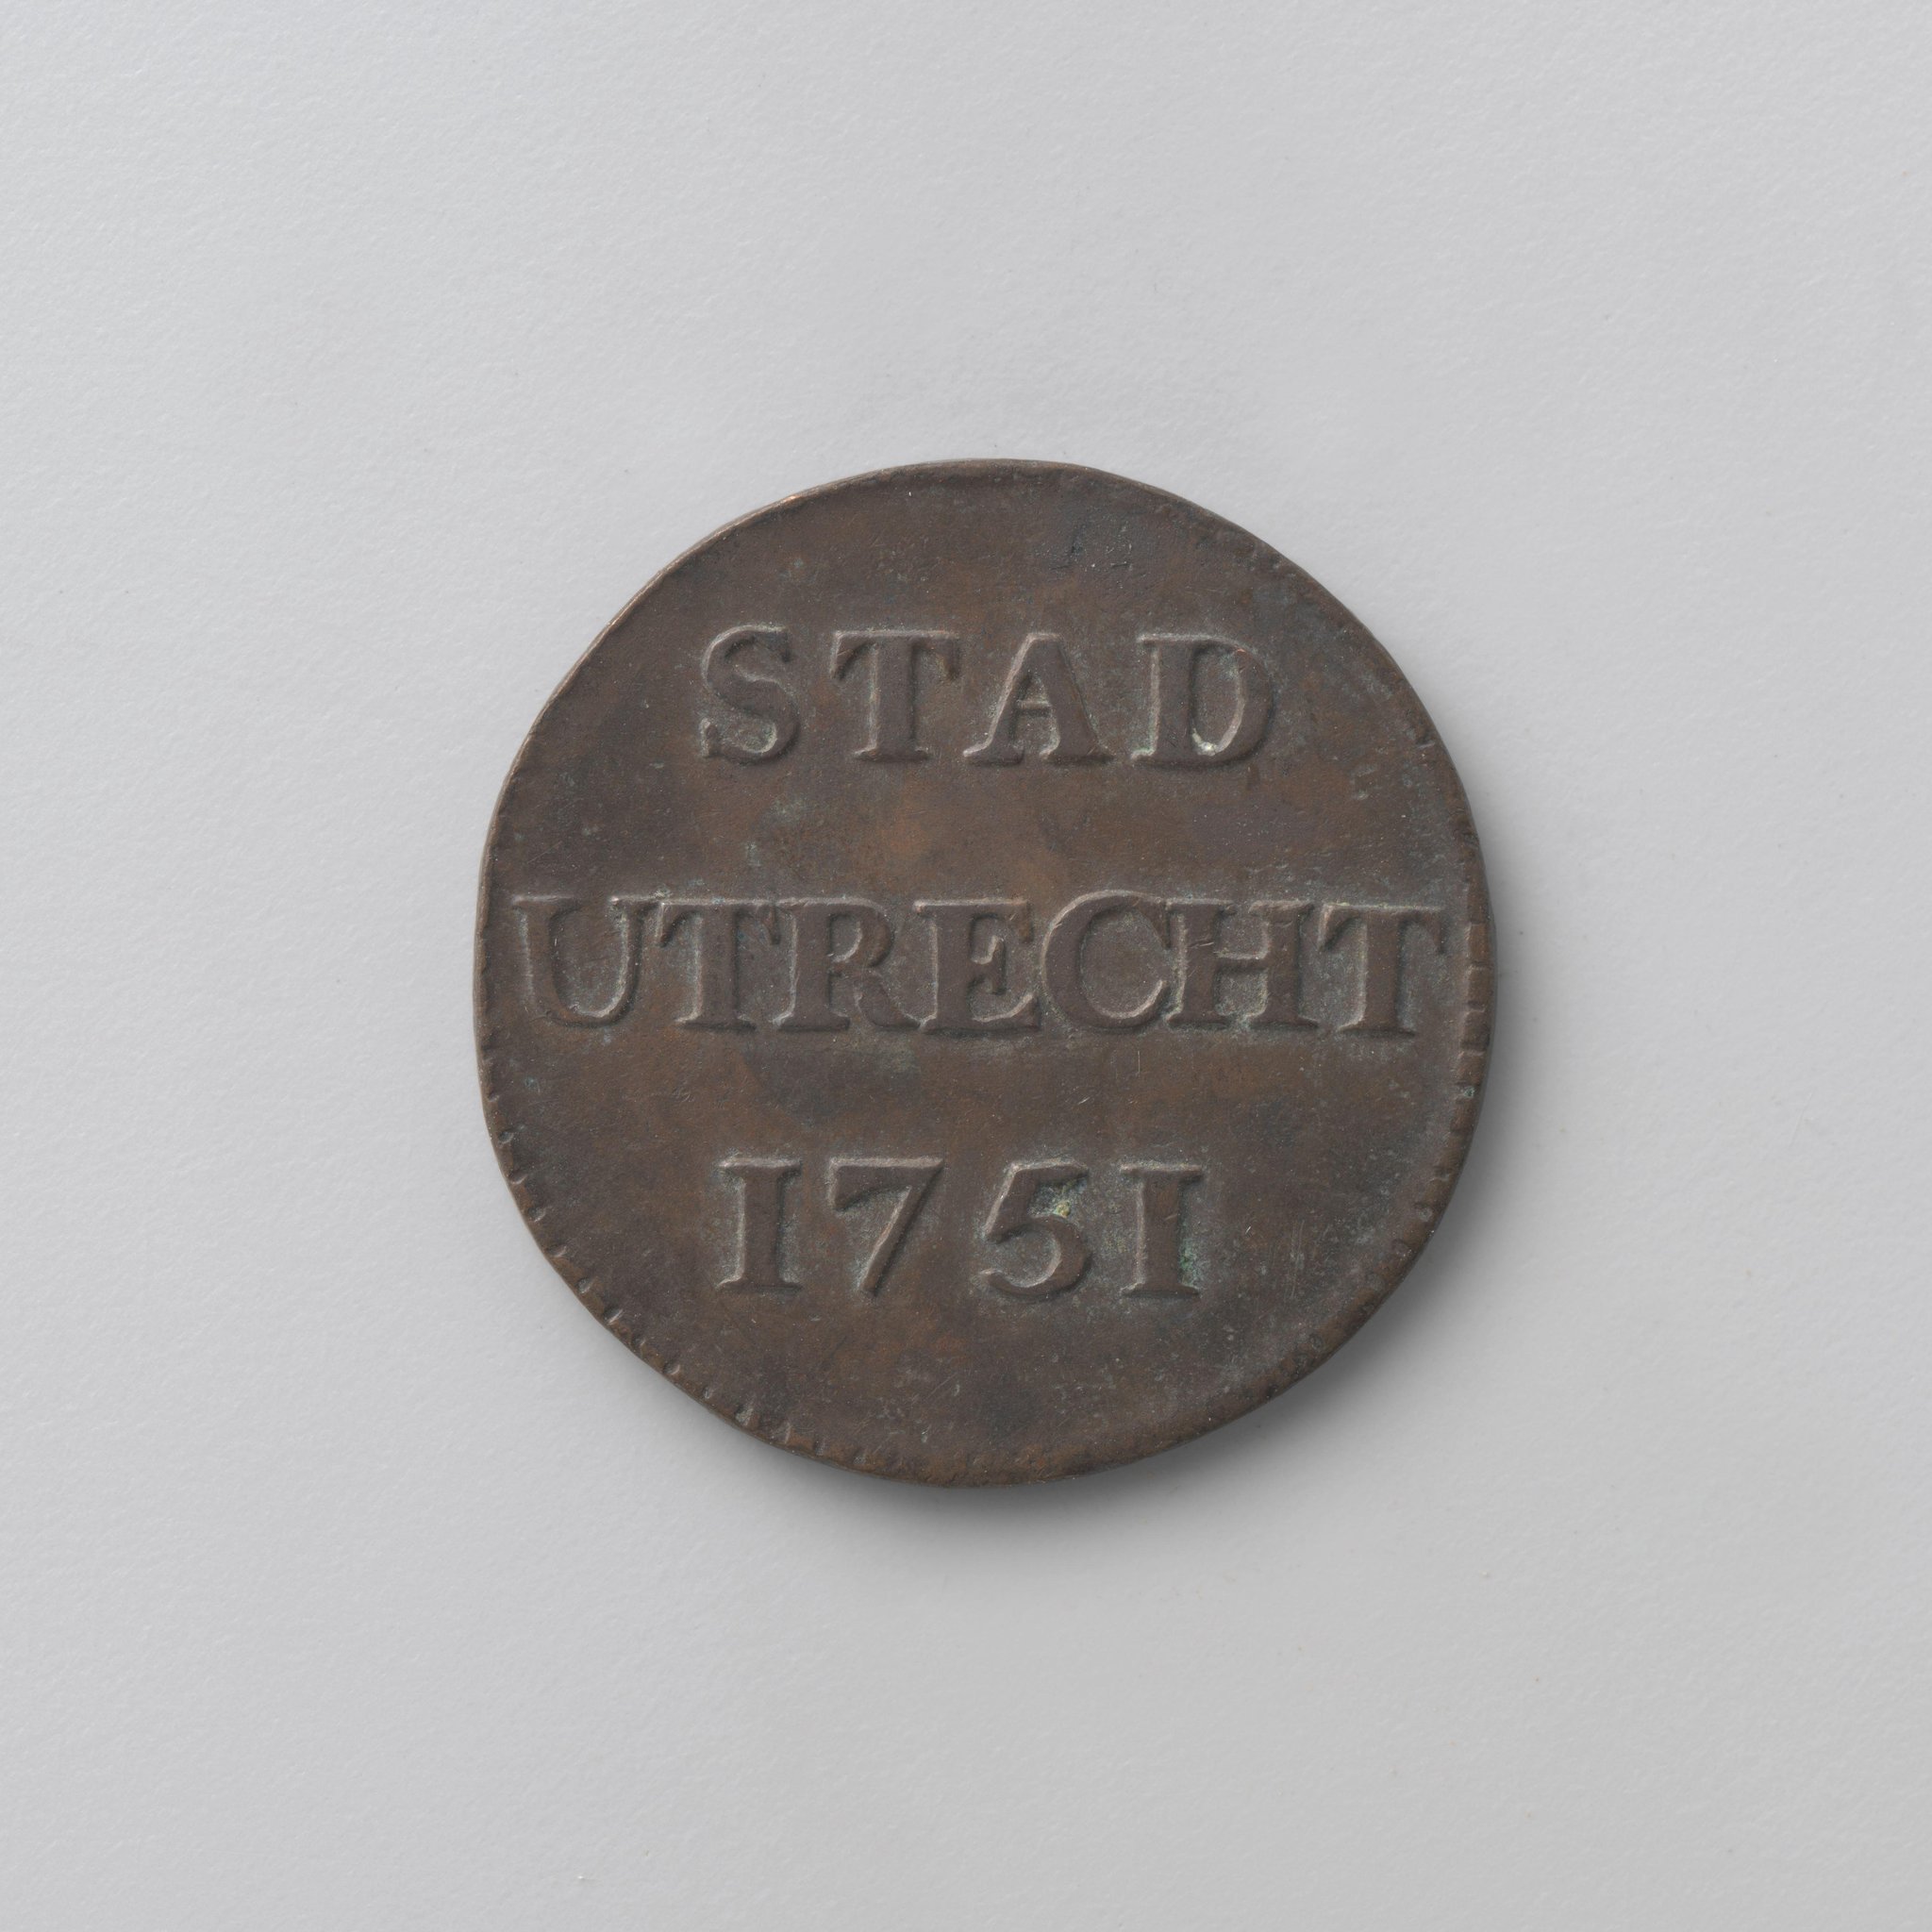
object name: coin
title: Stad Utrecht, duit, 1751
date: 1751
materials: copper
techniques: striking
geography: utrecht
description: Koperen munt. Voorzijde: gekroond stedelijk wapenschild, gehouden door twee leeuwen met in afsnede dunne lijn, waaronder een versierde accolade met een grote schelp. Keerzijde: opschrift in twee regels, waaronder jaartal. Jaartal met Romeinse I.